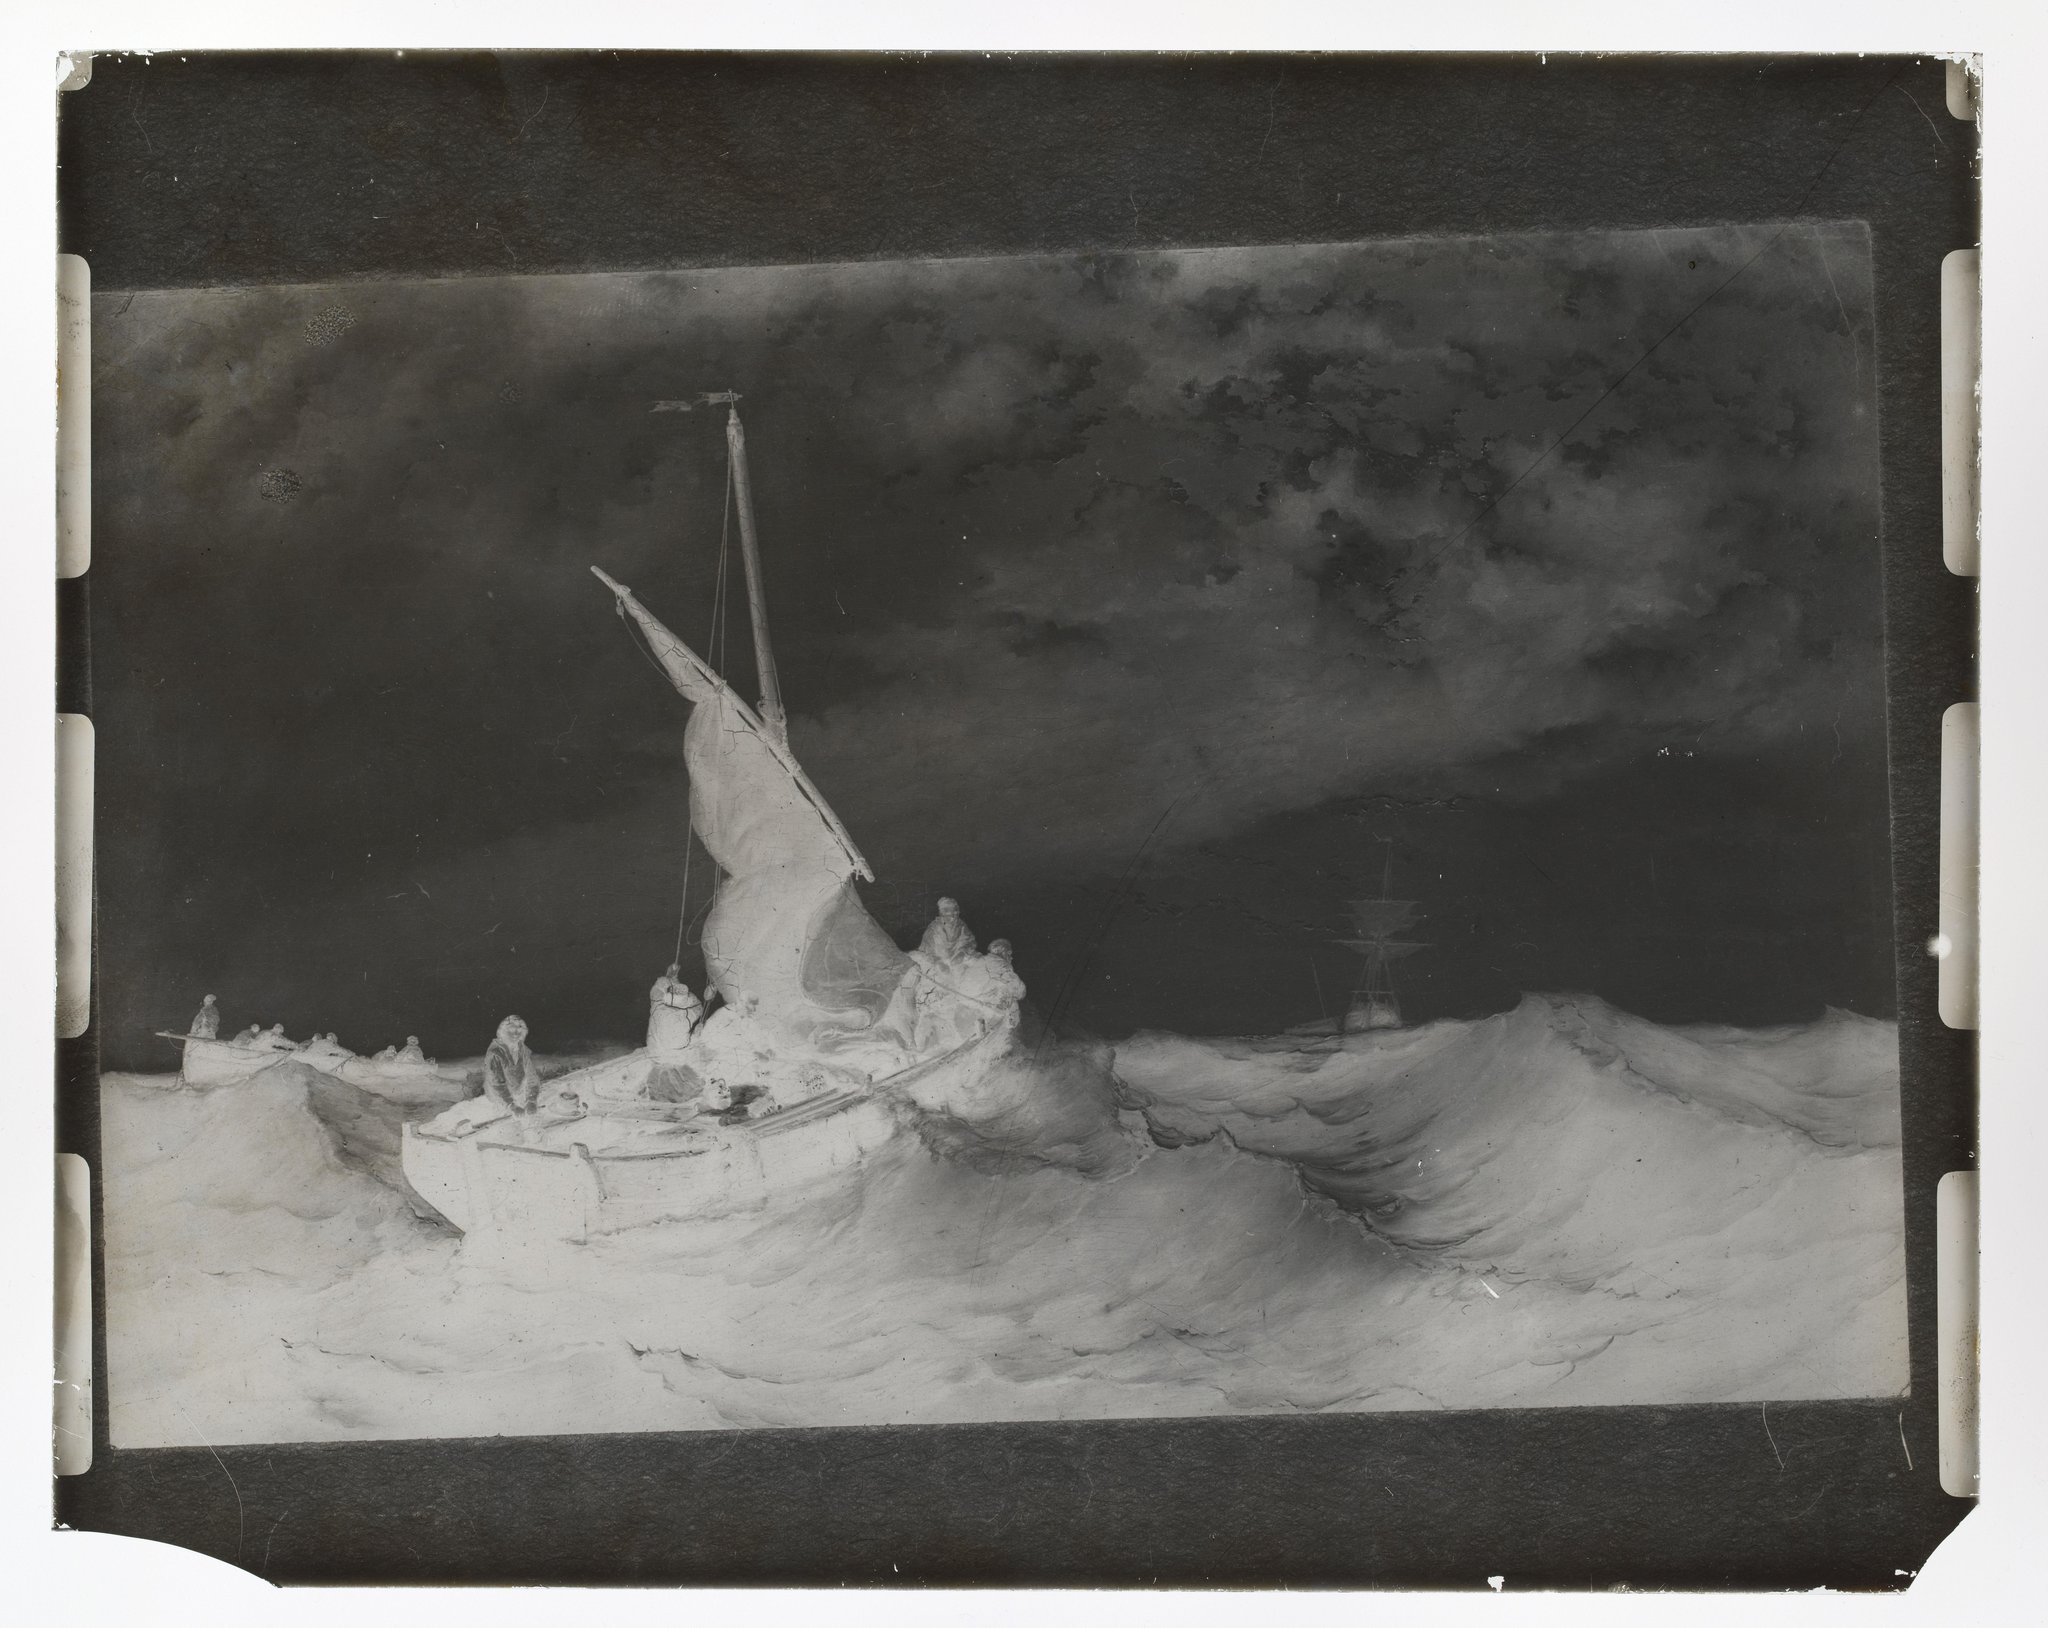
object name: glasnegatief, glasplaatnegatief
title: Fotoreproductie van een schilderij van een vissersboot op zee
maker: Anonymous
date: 1890-1930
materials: glass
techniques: gelatin glass negative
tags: sea and coastal fishery